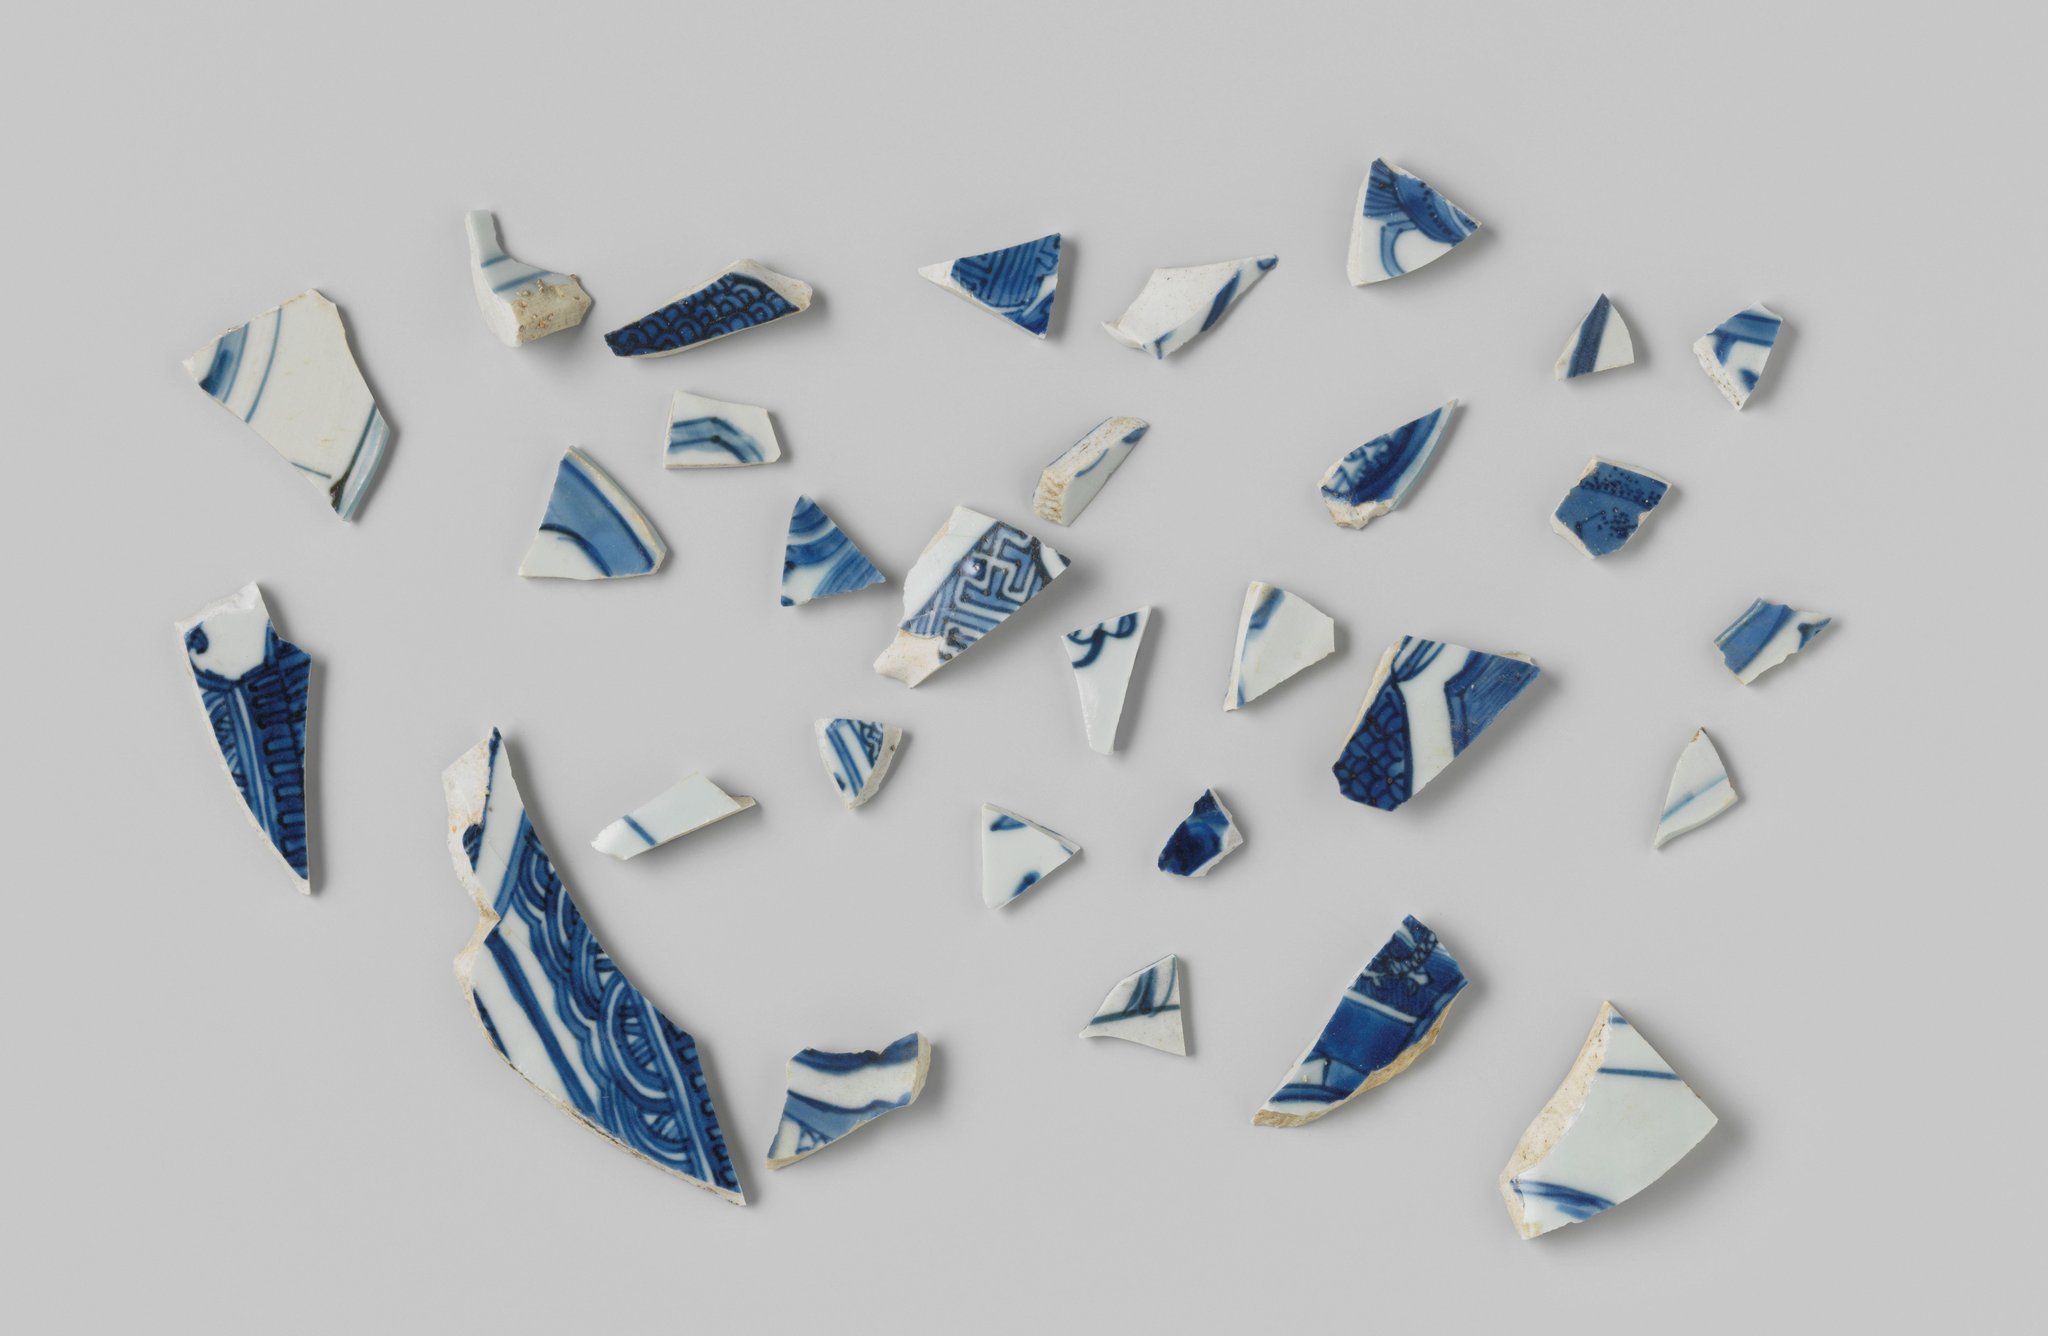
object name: plate dish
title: Scherven van borden uit V.O.C.-schip de 'Witte Leeuw'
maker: Anonymous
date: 1613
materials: bone china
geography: jingdezhen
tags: verenigde oostindische compagnie, sint-helena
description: Scherven van borden uit V.O.C.-schip de 'Witte Leeuw'.